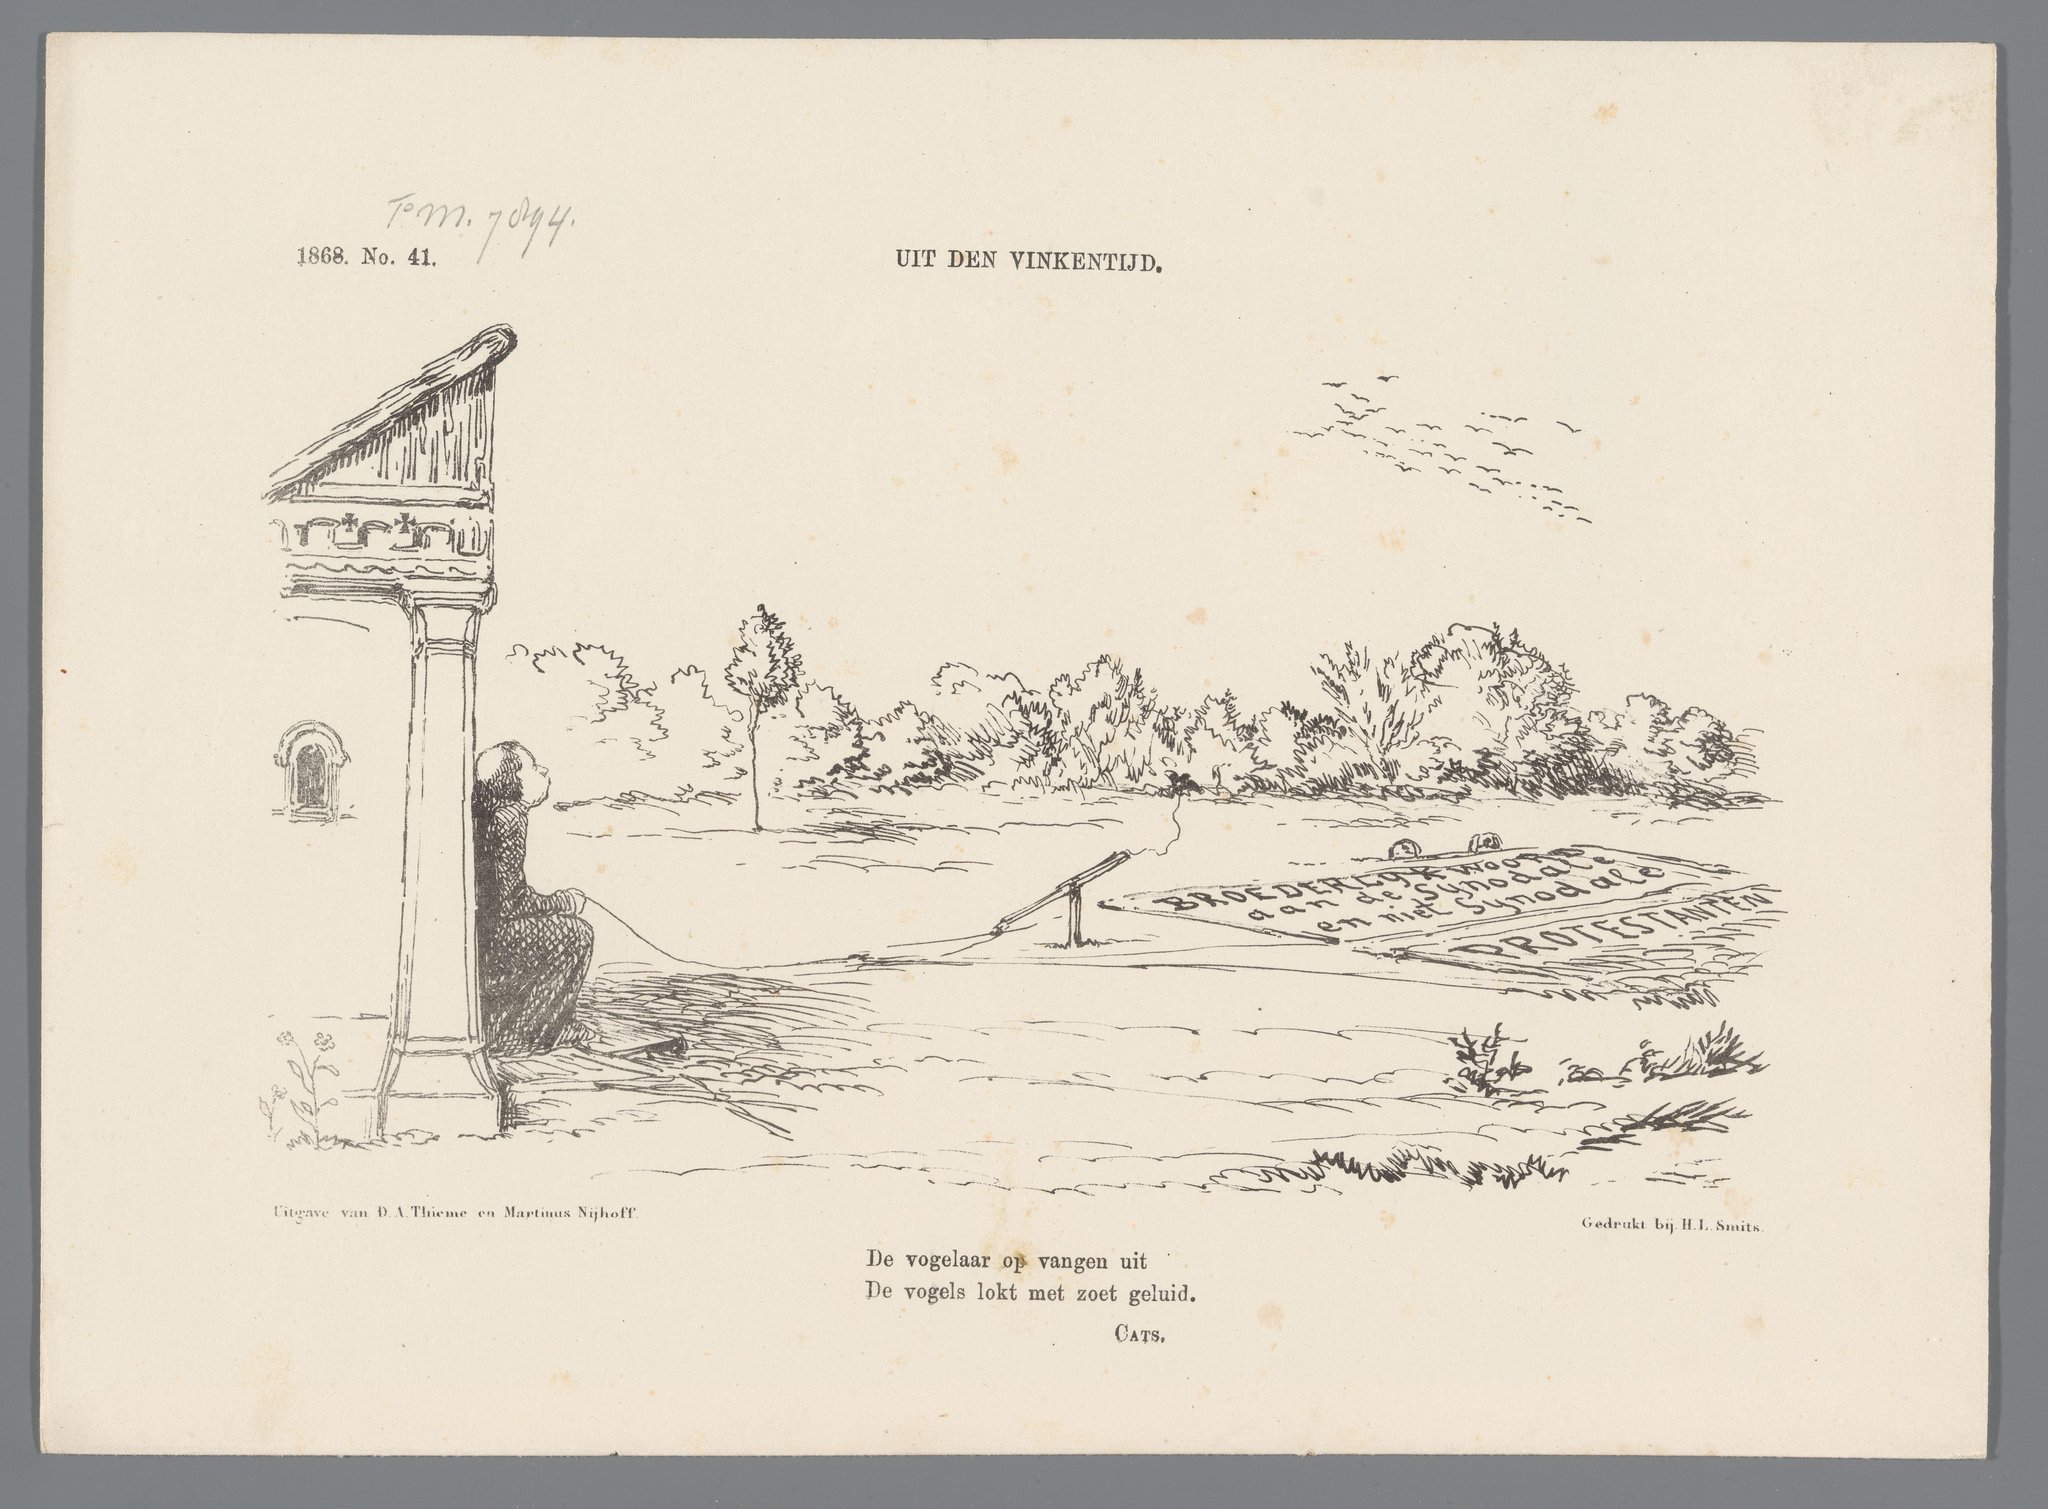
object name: cartoon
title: Spotprent op abt Brouwers, 1868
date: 1867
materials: paper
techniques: lithograph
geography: netherlands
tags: priest, finch trap, finchery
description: Spotprent met abt Brouwers die als een vinker vogels met een vinkennet probeert te vangen, nav een conciliant geschrift van Brouwers. Met tweeregelig vers van Cats. Plaat verschenen bij het weekblad De Nederlandsche Spectator, nr. 41, 10 oktober 1868.